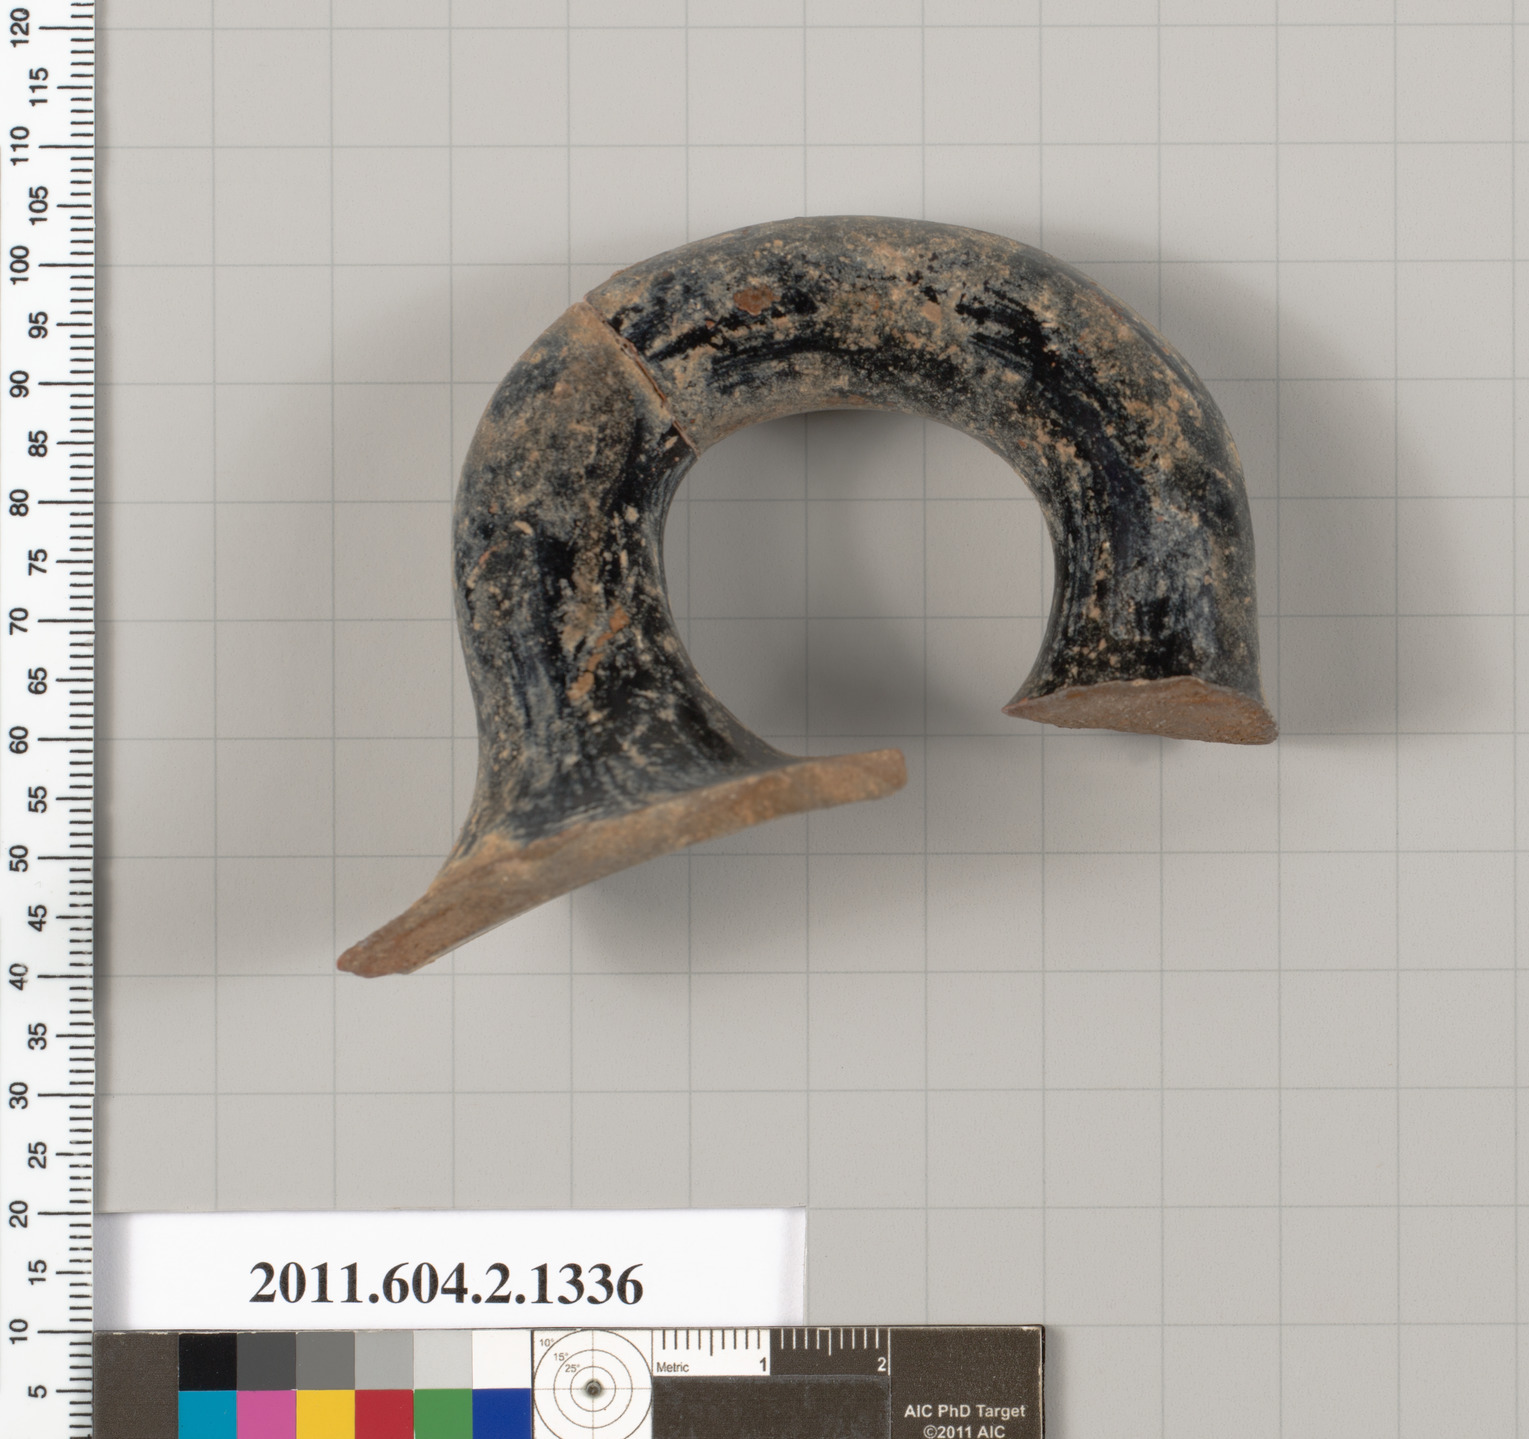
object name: skyphos fragment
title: Terracotta fragment of a skyphos (deep drinking cup)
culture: greek, attic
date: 500-451 BCE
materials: terracotta